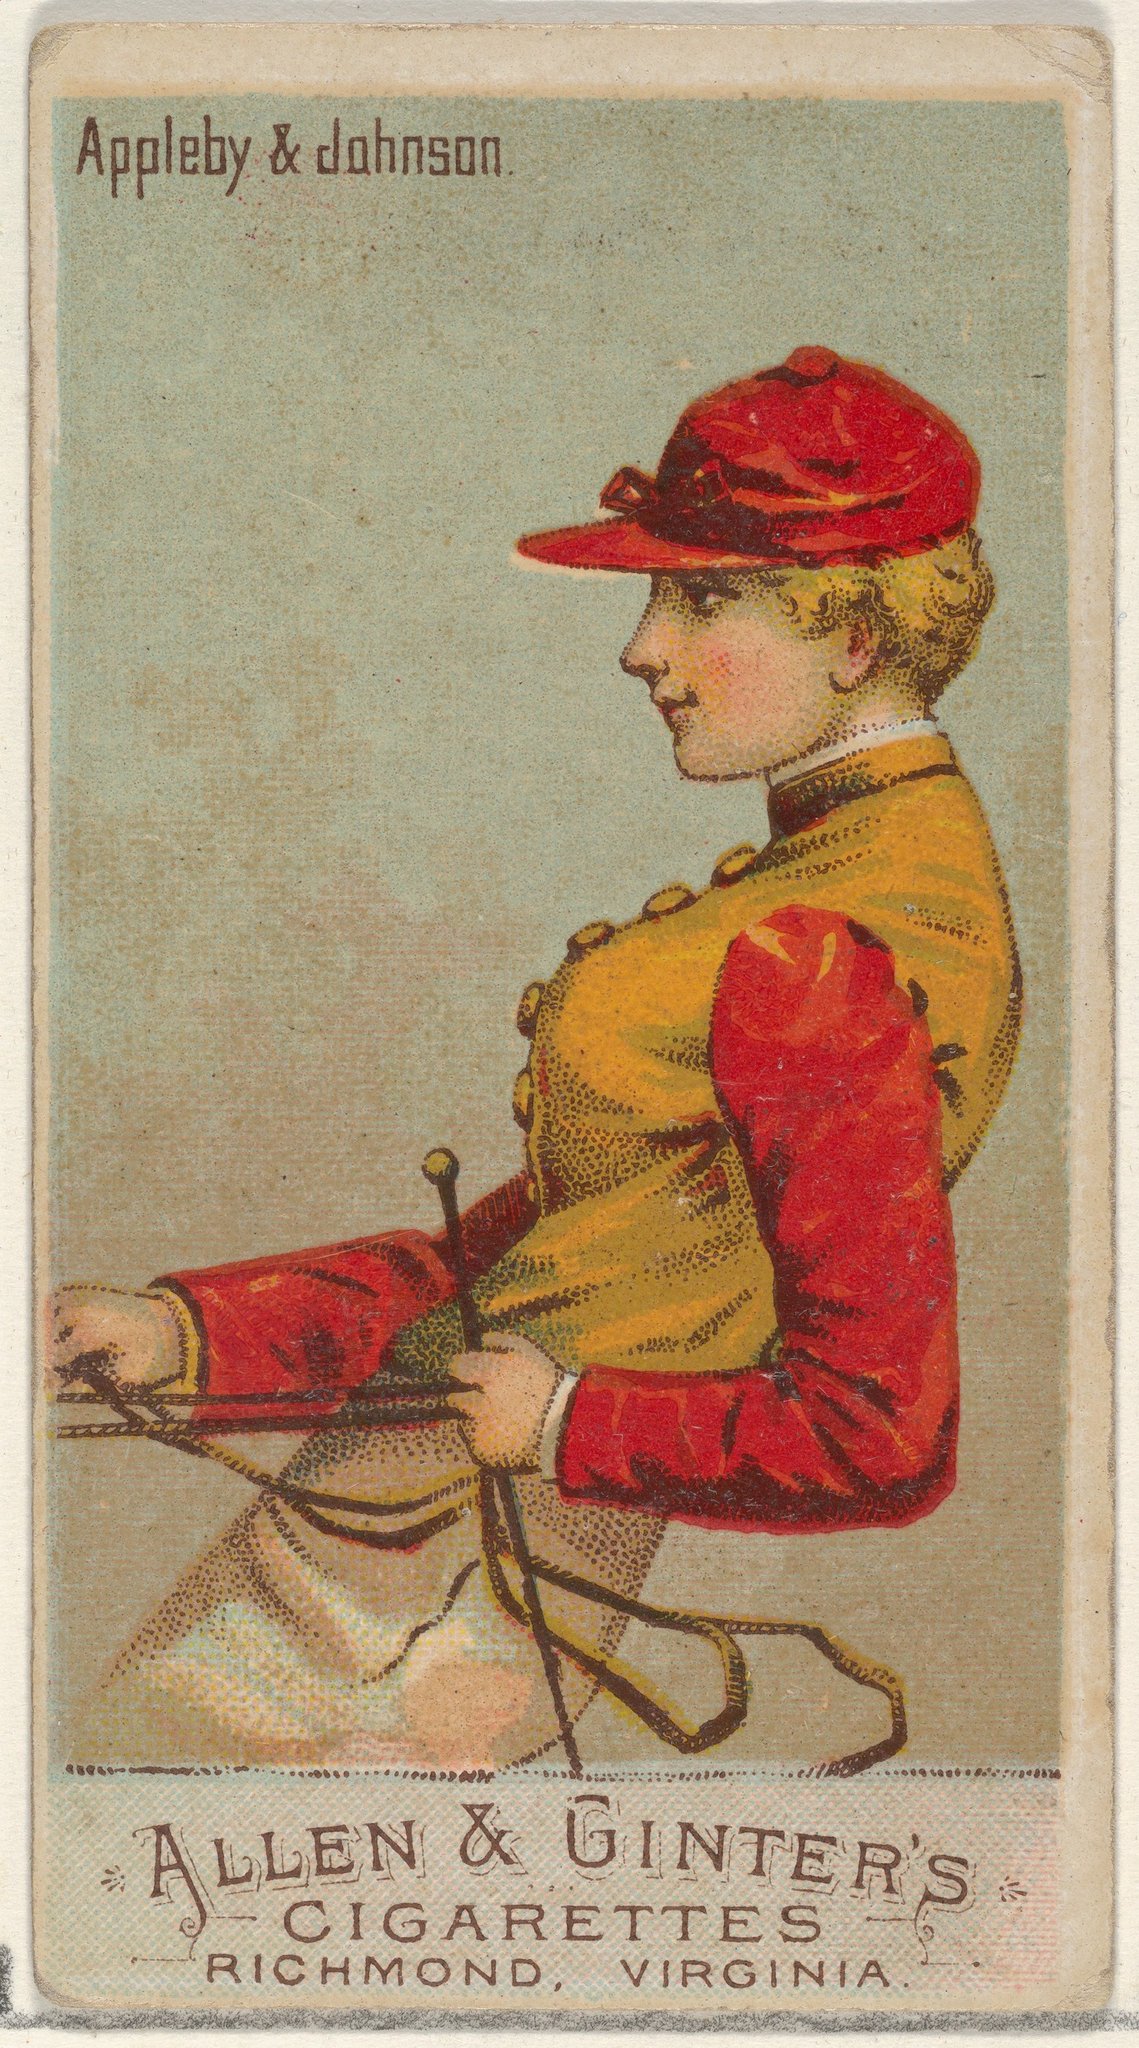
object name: print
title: Appleby & Johnson, from the Racing Colors of the World series (N22a) for Allen & Ginter Cigarettes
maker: allen & ginter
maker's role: publisher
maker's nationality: american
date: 1888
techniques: color lithograph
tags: profiles,women,jockeys